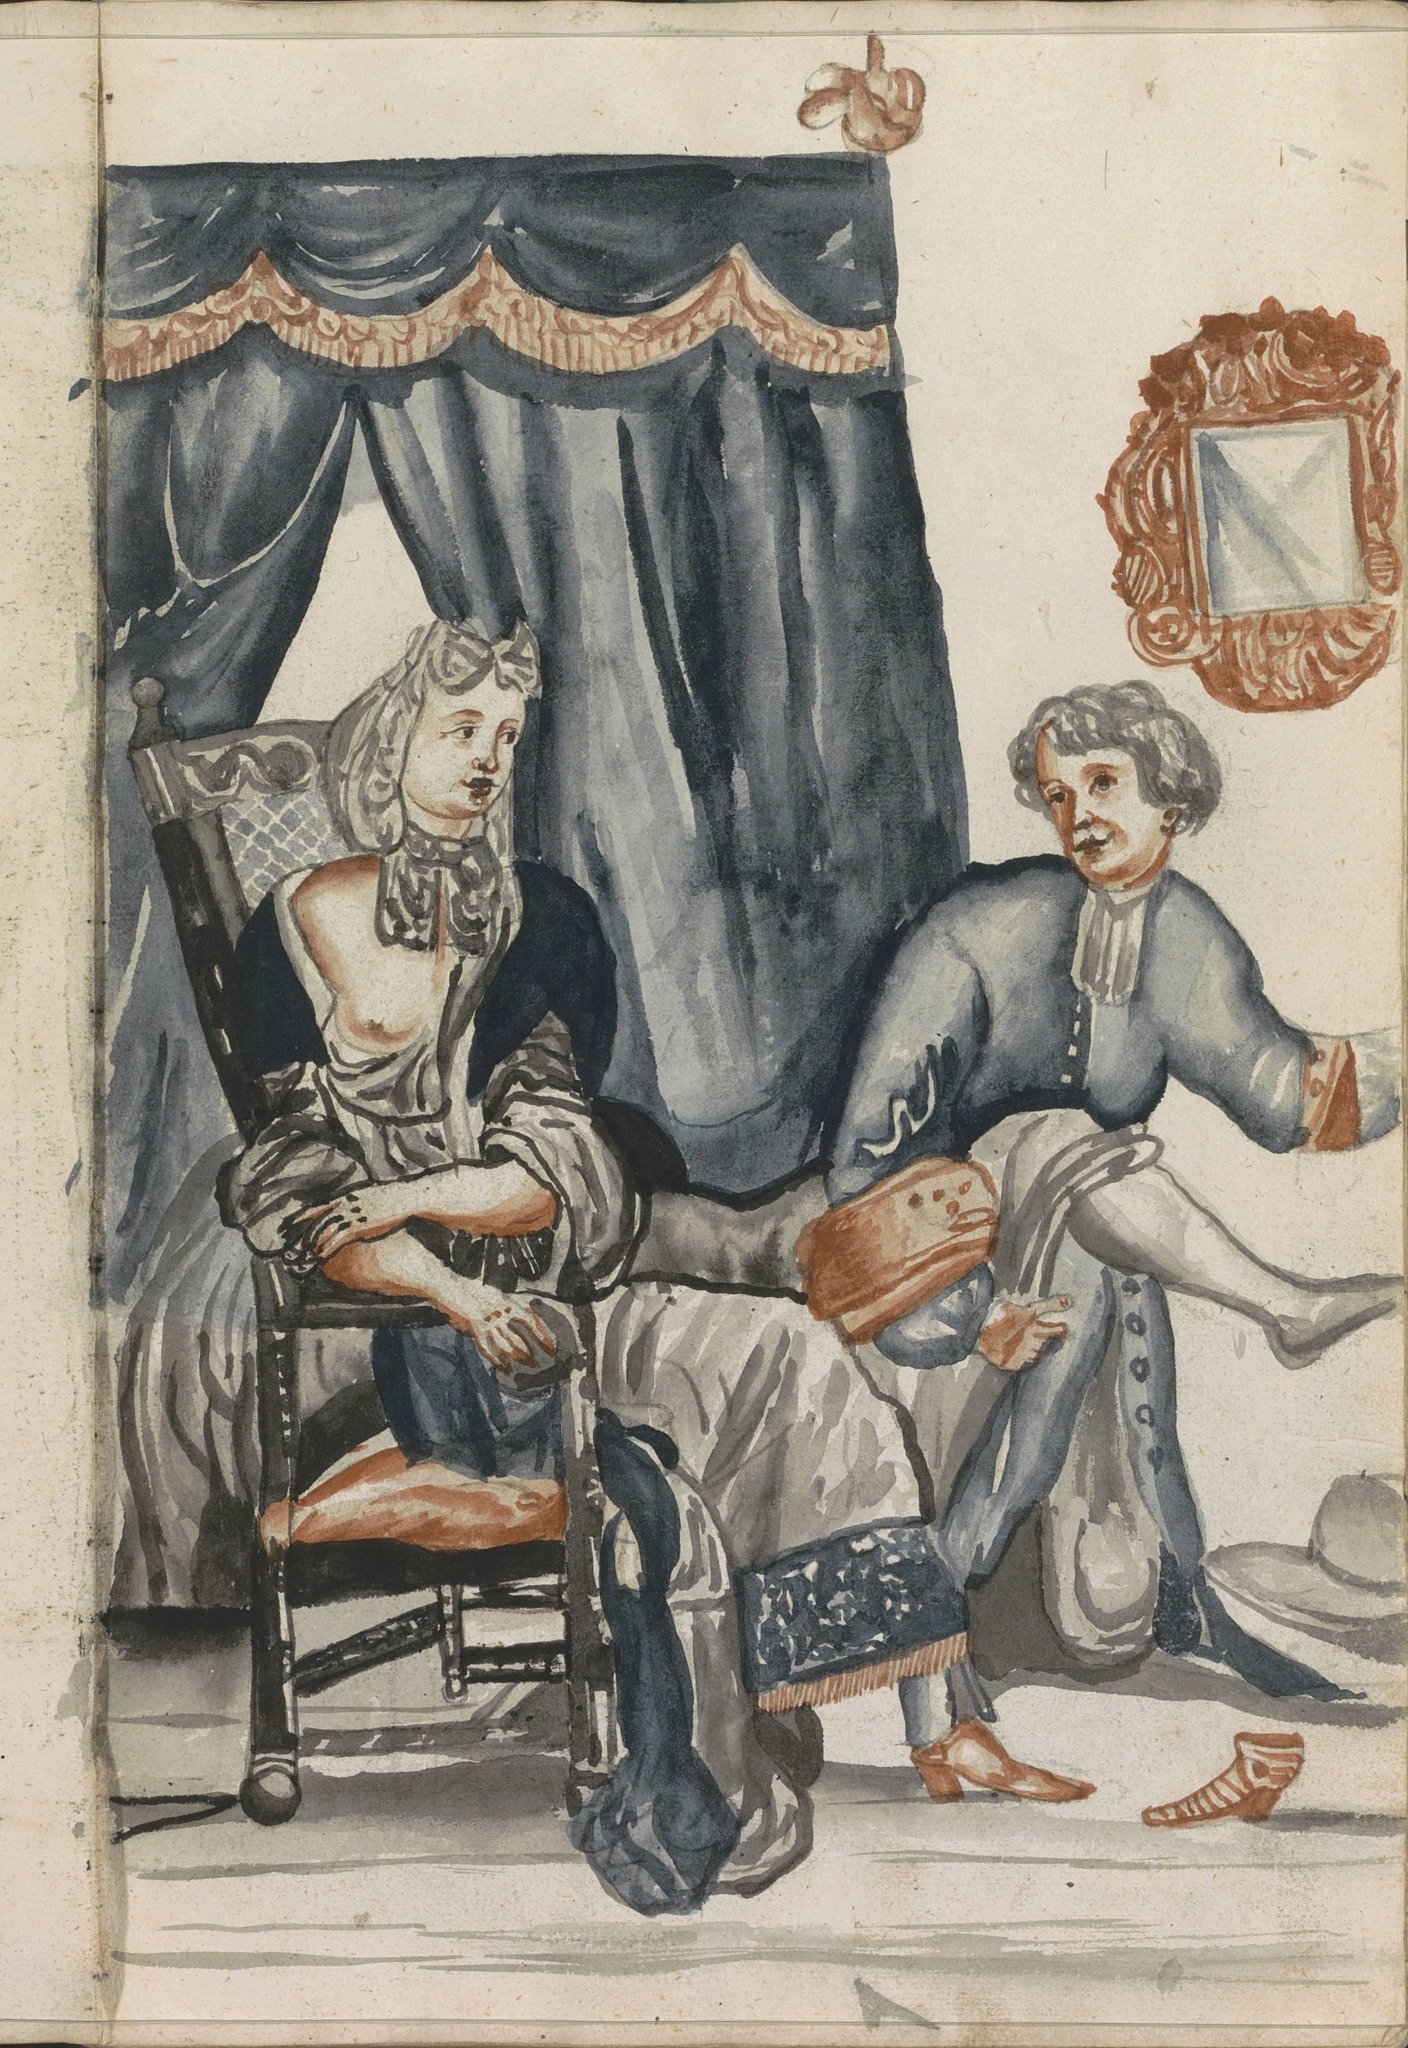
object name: sketchbook leaf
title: Vrouw met ontblote borst zittend voor een hemelbed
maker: hendrick van beaumont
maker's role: draughtsman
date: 1696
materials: paper, watercolor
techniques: brush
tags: breasts, interior of the house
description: De vrouw heeft één been omhoog gestoken. Dit been wordt gedragen door een man die naast haar stoel staat. Mogelijk getekend naar een prent. Blad 31 recto uit een schetsboek met 91 bladen.